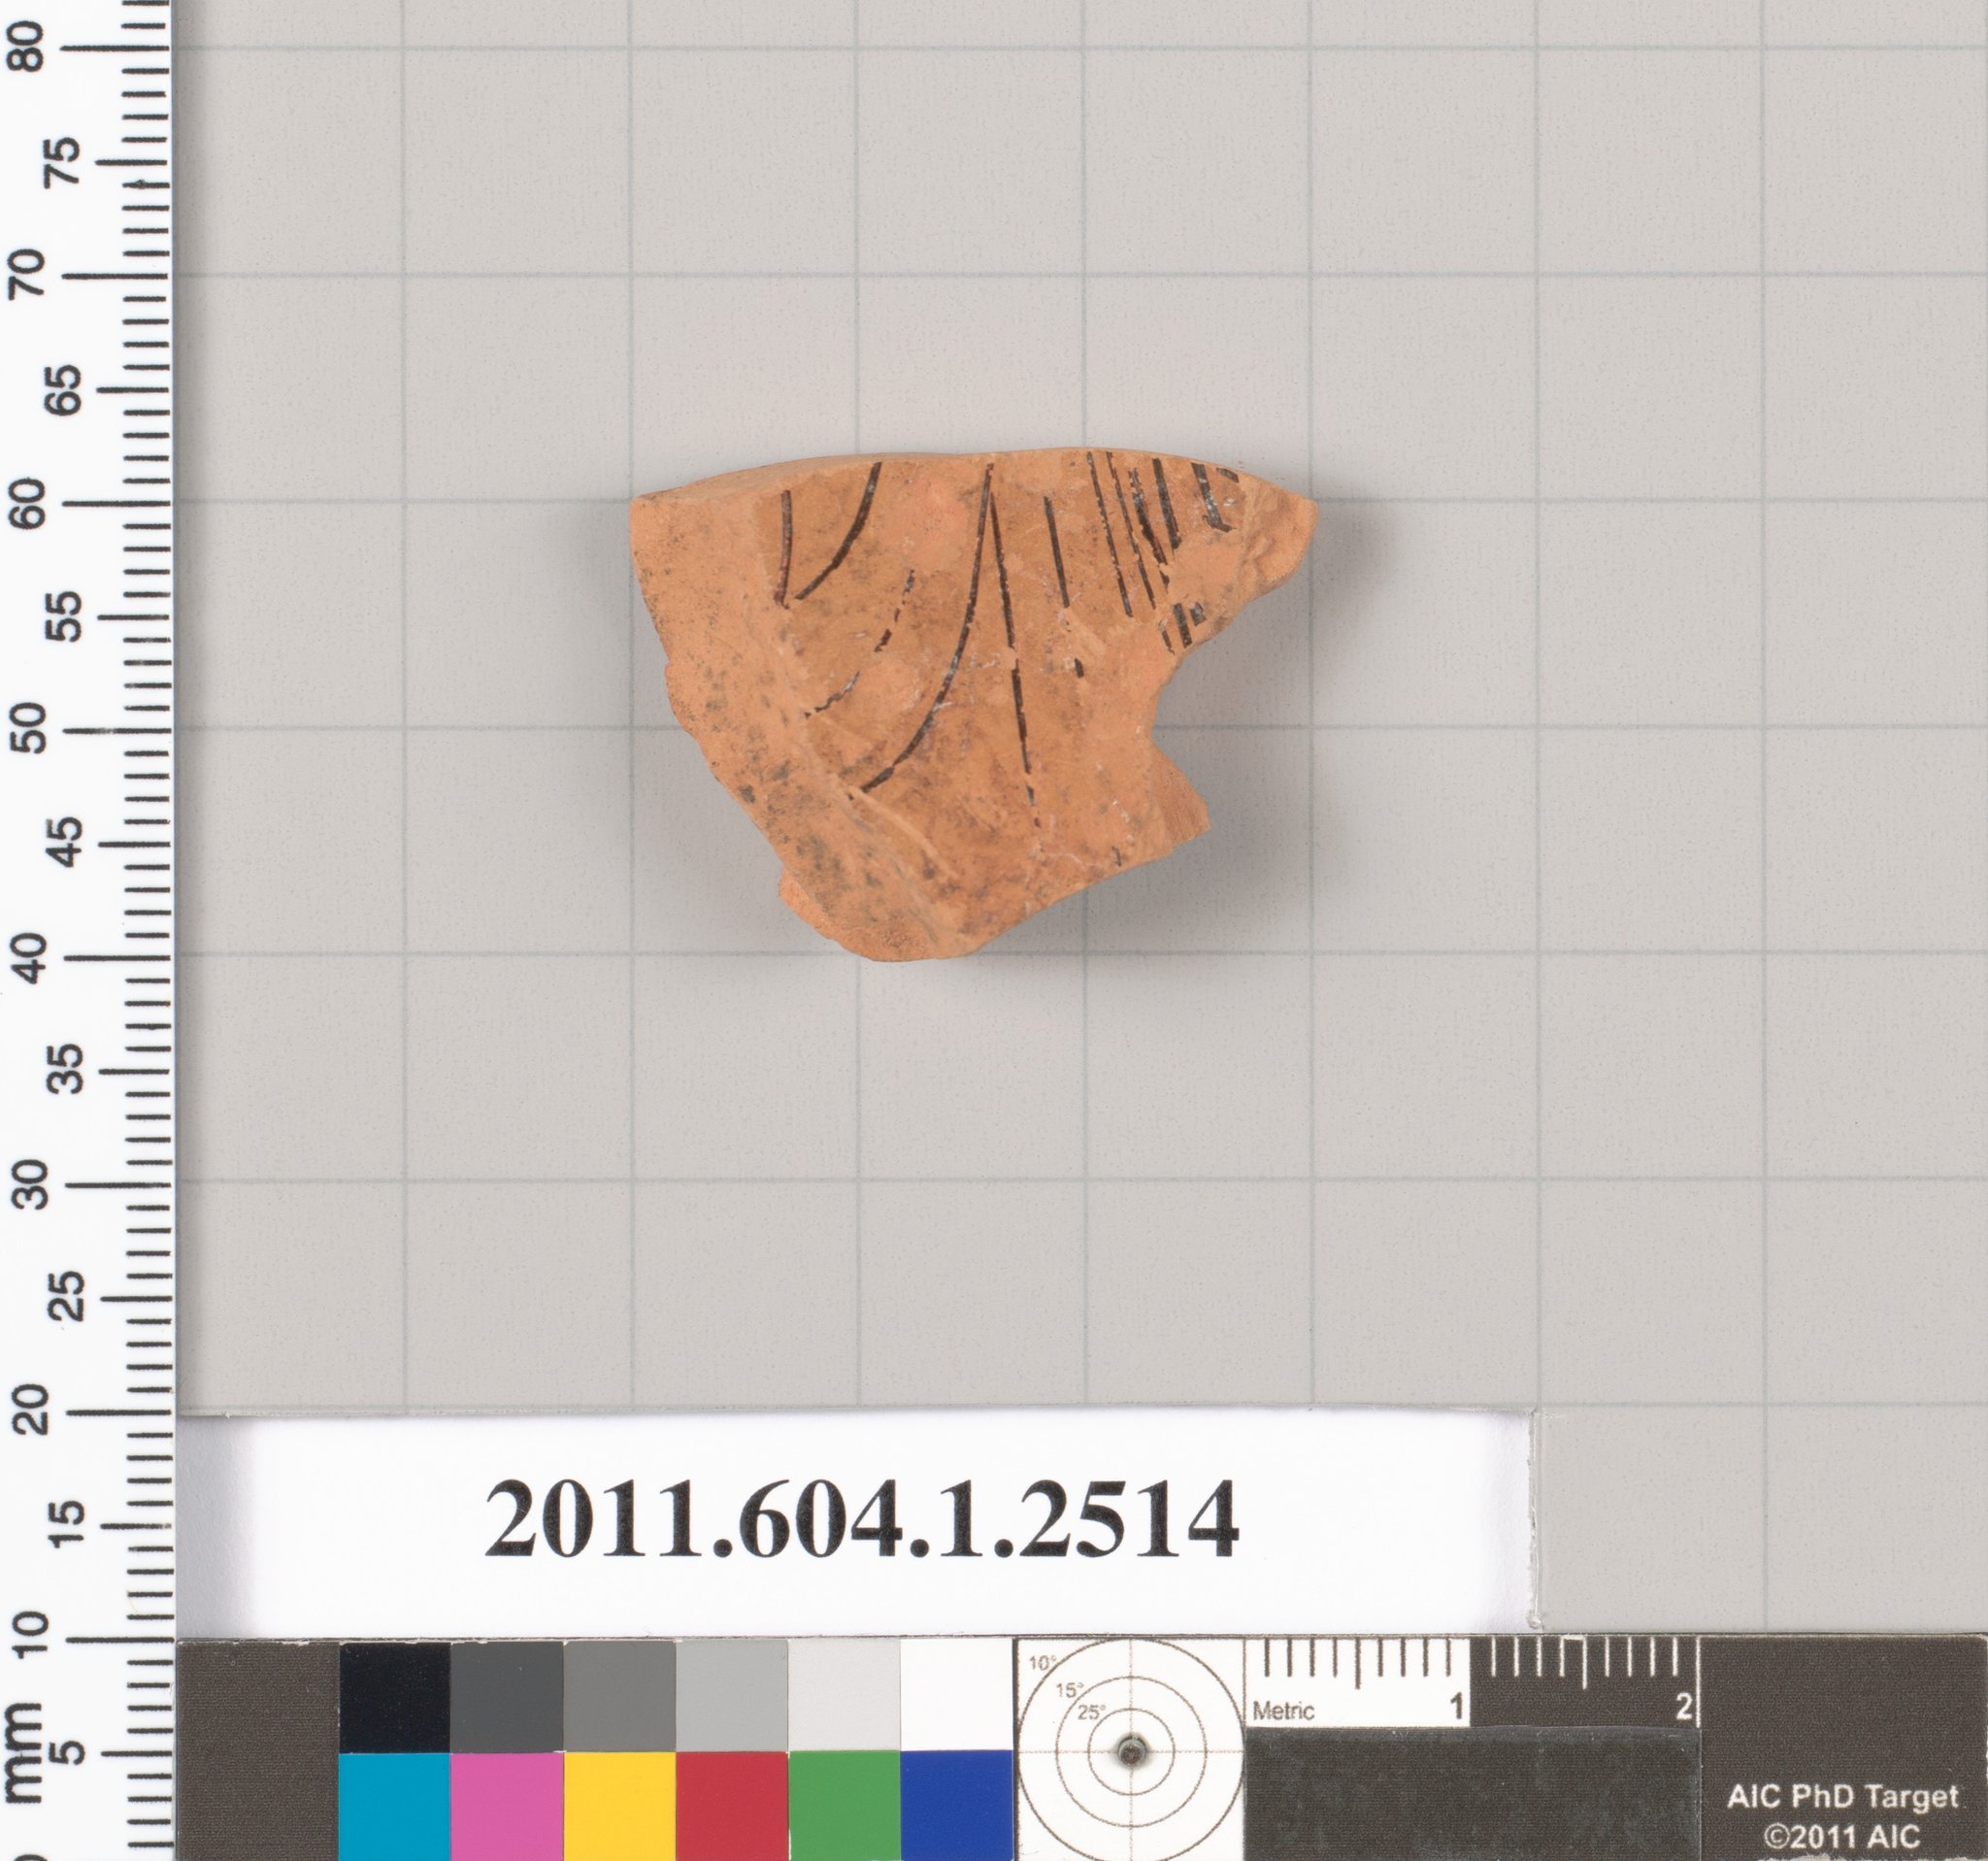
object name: kylix fragment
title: Terracotta fragment of a kylix (drinking cup)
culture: greek, attic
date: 475-451 BCE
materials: terracotta